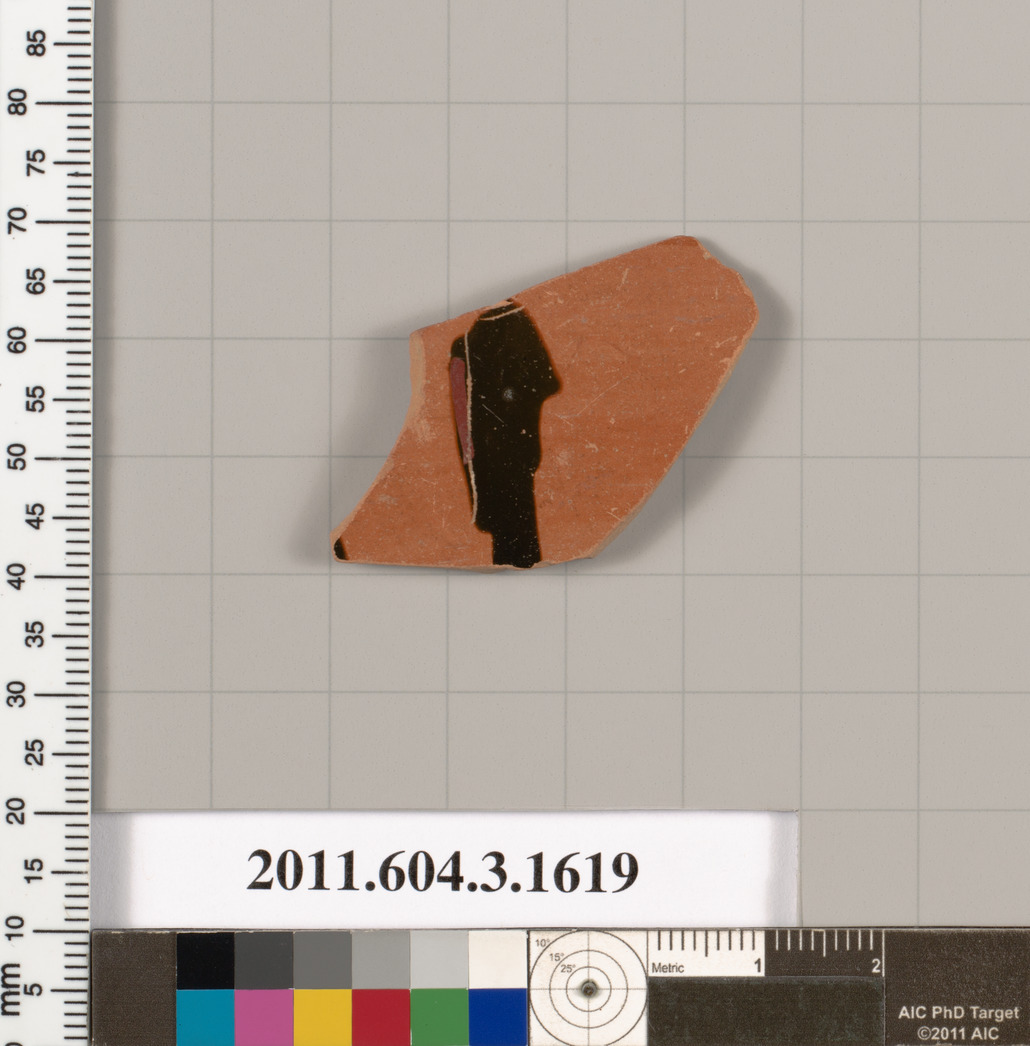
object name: kylix fragment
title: Terracotta fragment of a kylix: Band cup (drinking cup)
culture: greek, attic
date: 550-526 BCE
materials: terracotta